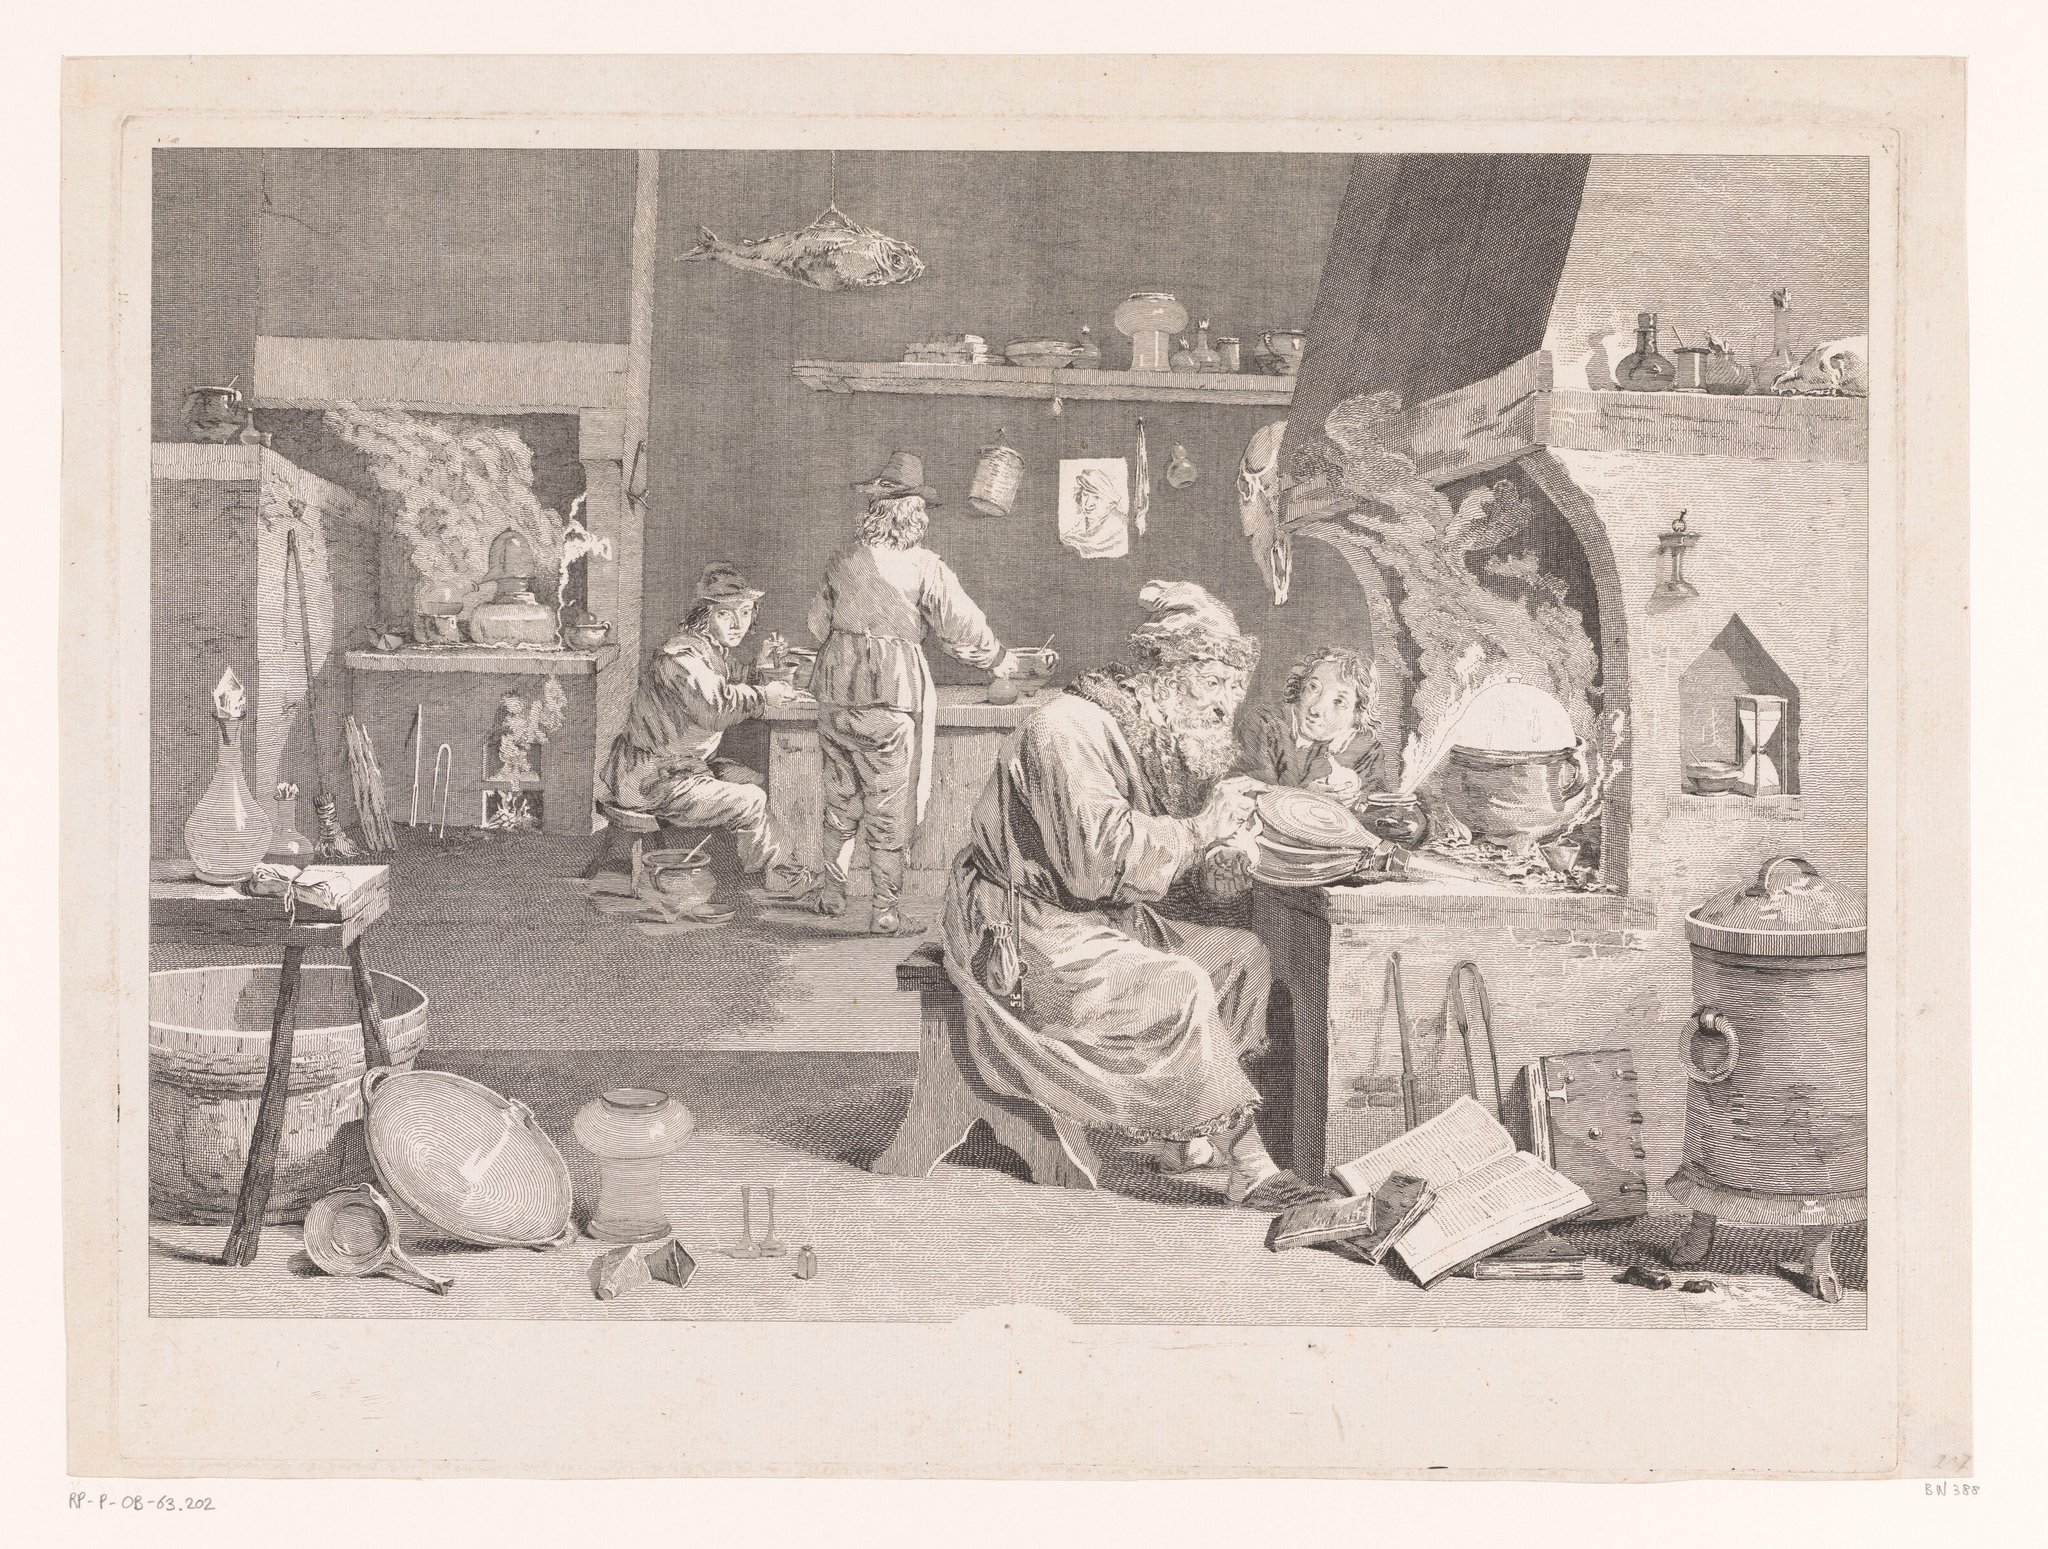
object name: print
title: Le Chimiste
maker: jacques-philippe le bas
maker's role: draughtsman, print maker, publisher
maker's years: 1707-1783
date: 1747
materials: paper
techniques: etching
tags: alchemist at work, laboratory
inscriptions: collector's mark: Lugt 240